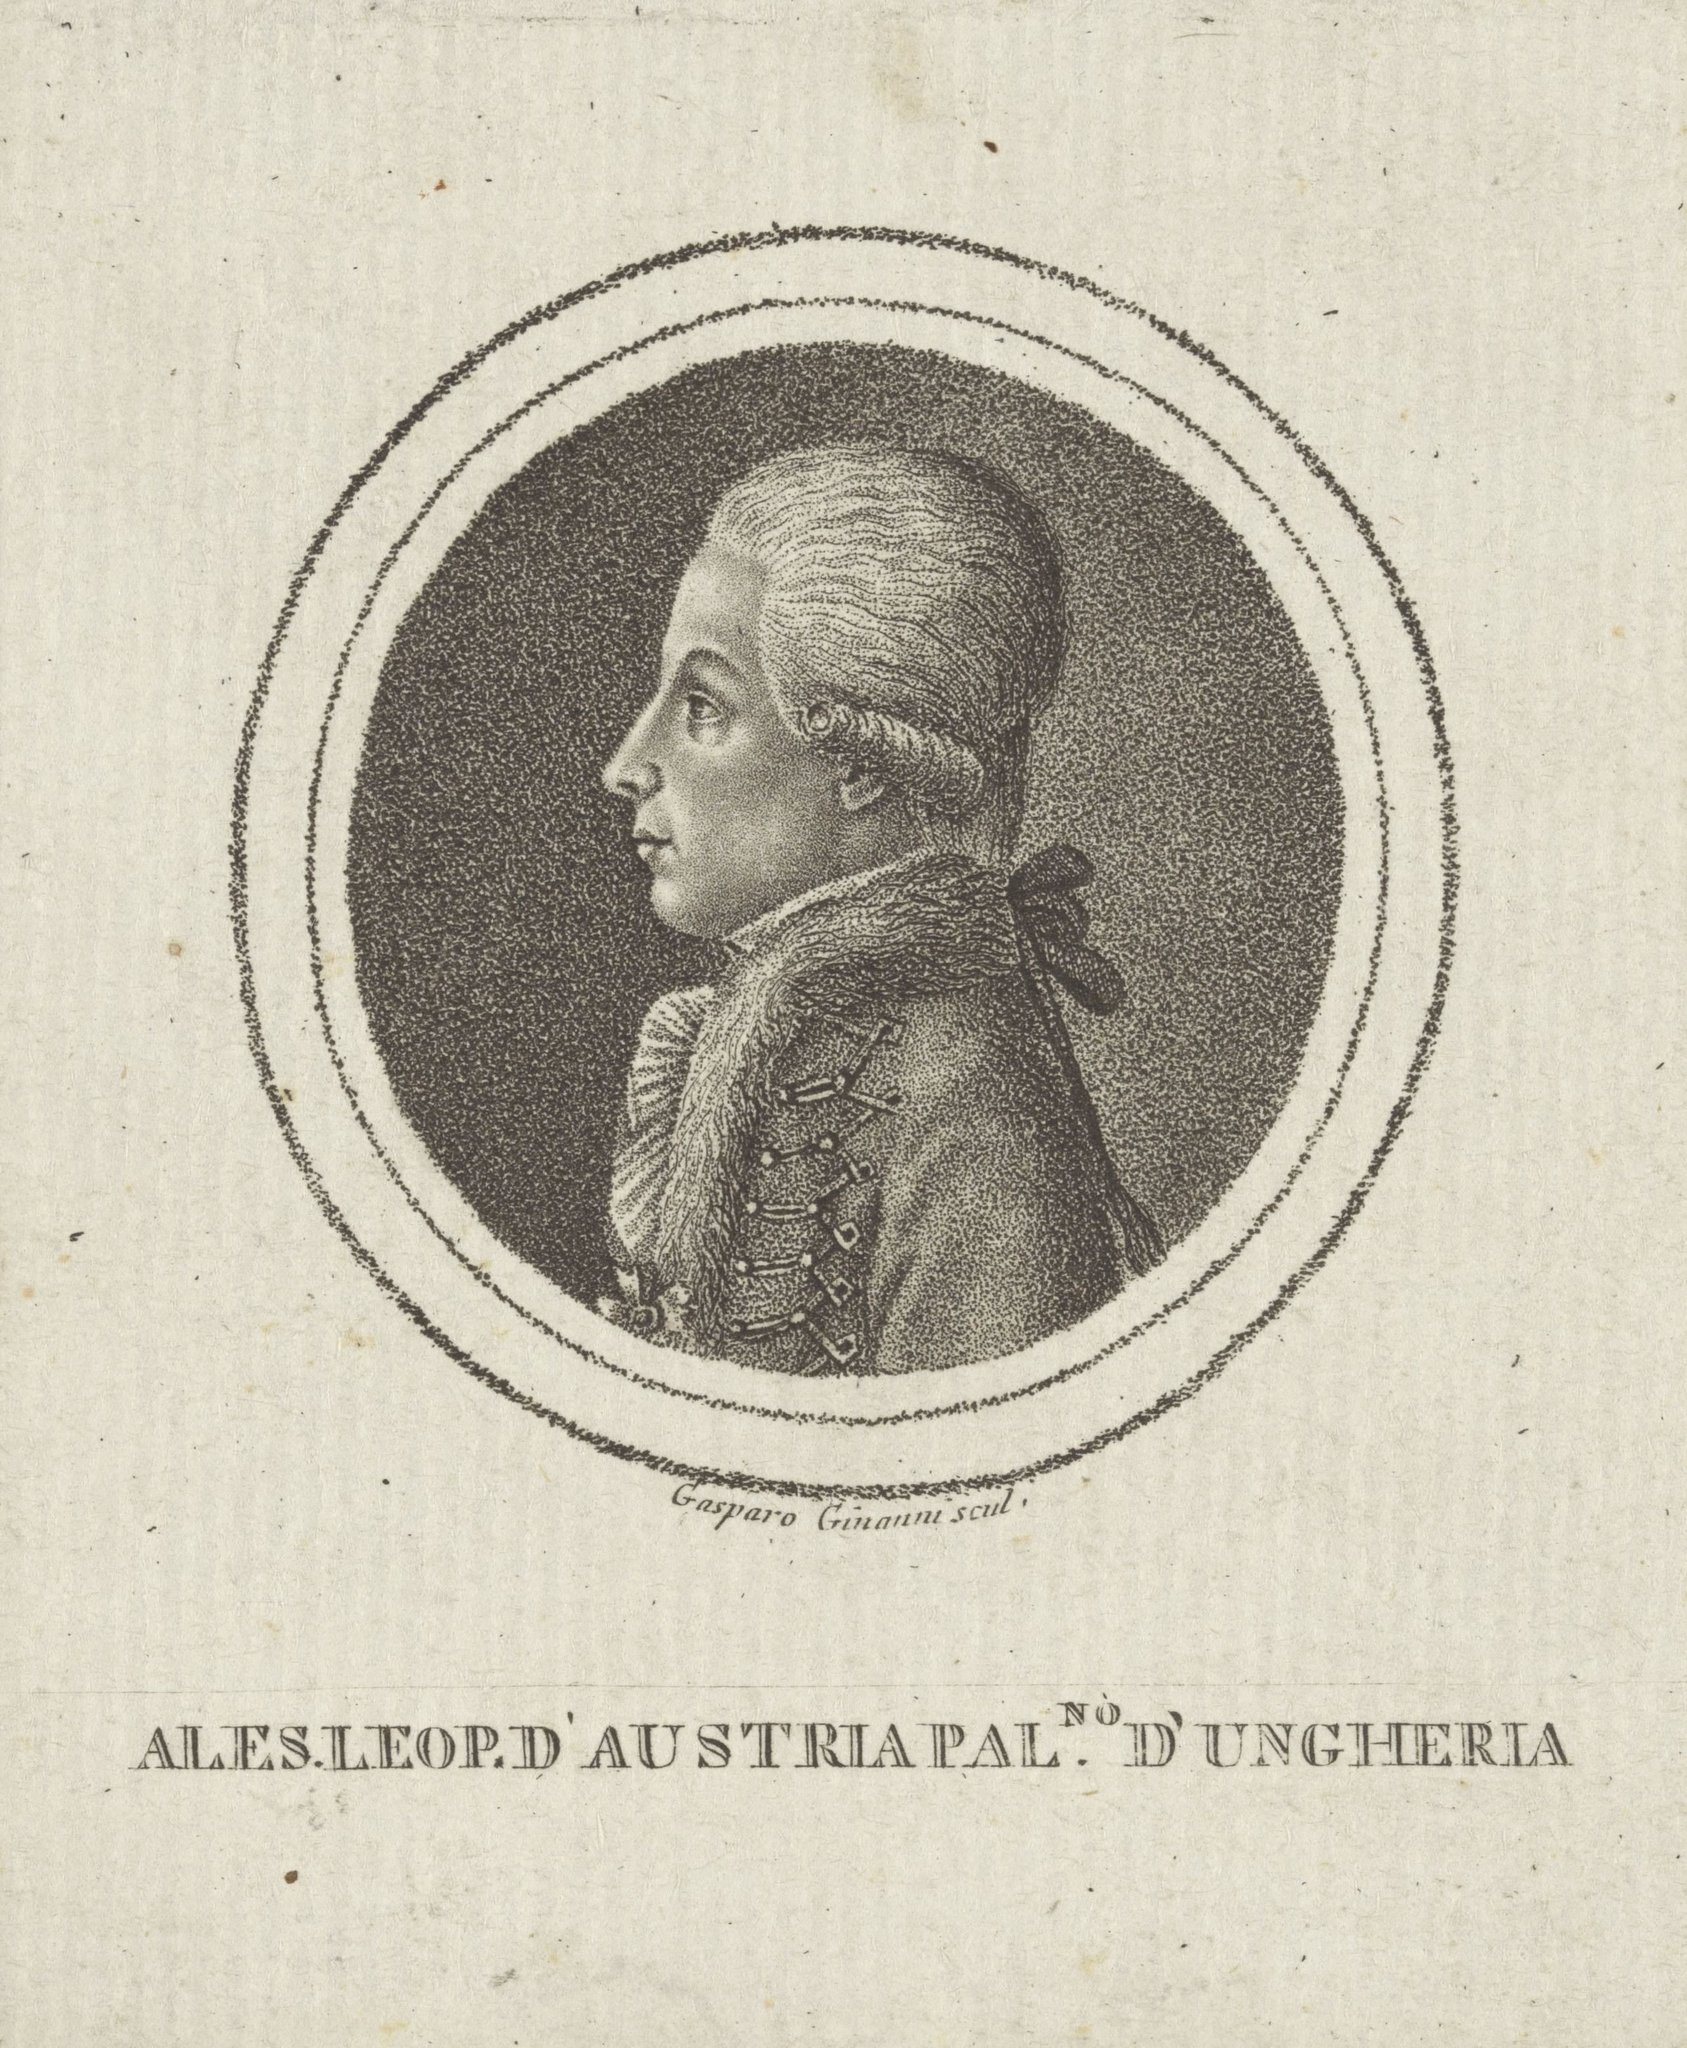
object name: print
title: Portret van keizer Leopold II van Oostenrijk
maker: gaspare ginanni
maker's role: print maker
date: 1791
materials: paper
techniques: stippling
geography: italy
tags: leopold ii (keizer van oostenrijk), historical persons, ruler, sovereign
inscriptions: collector's mark: Lugt 2228